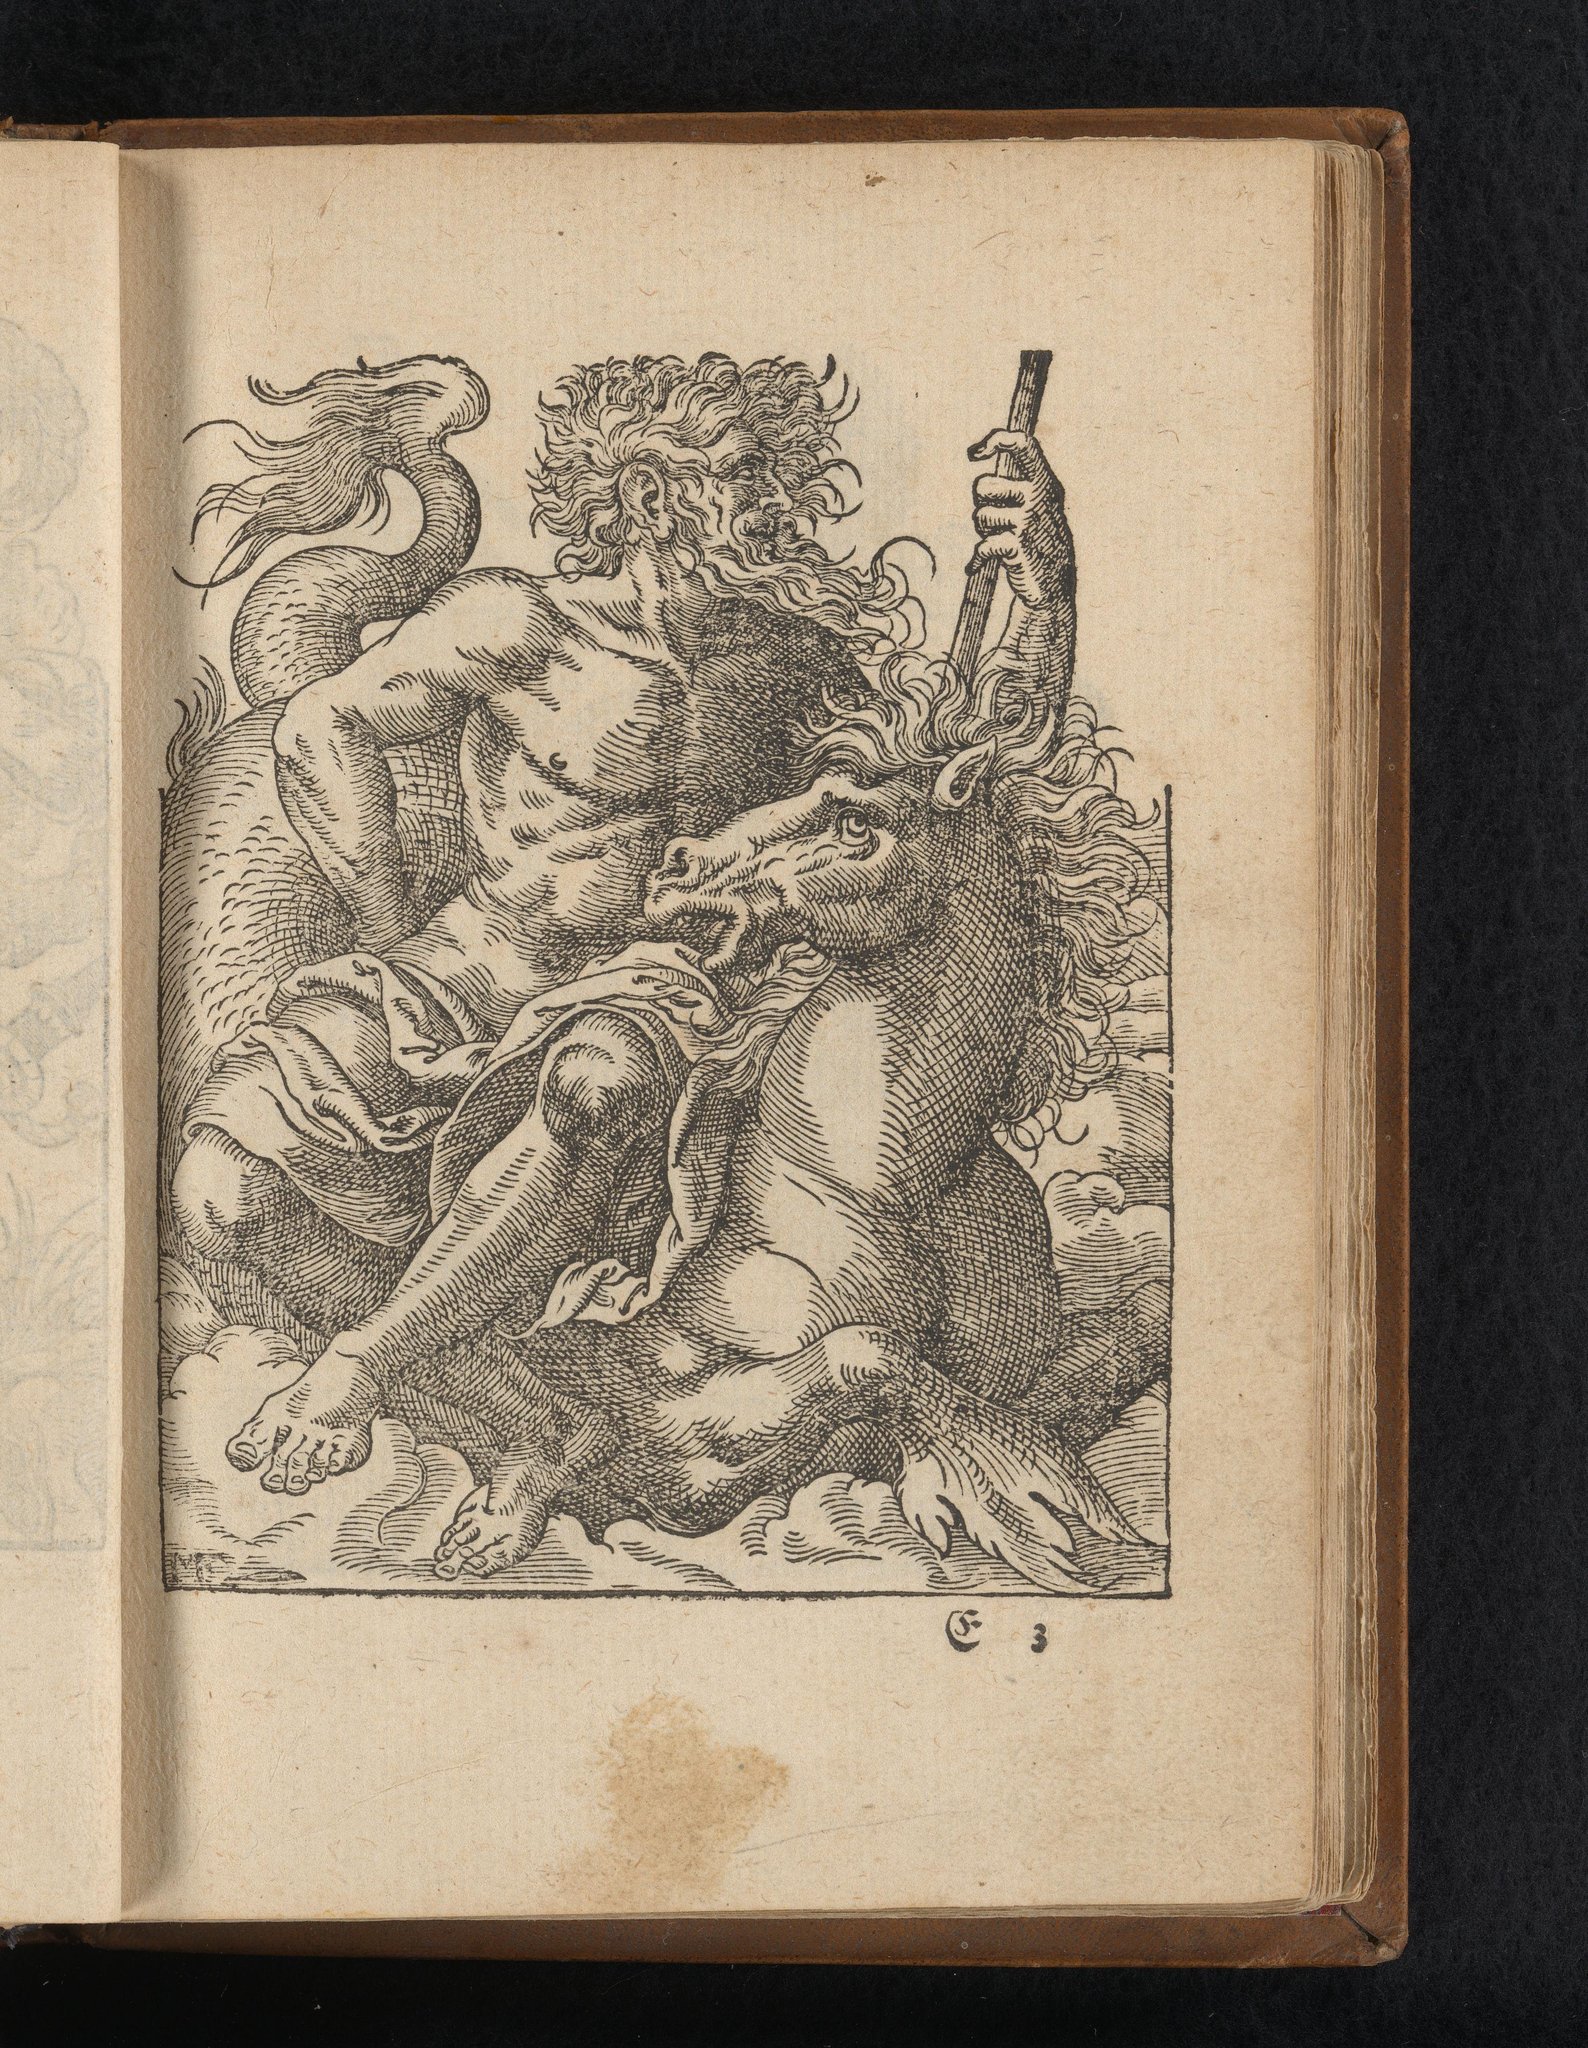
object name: print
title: Neptunus op een zeepaard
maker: monogrammist mf (duitsland)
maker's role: houtsnijder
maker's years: 1550-1599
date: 1578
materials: paper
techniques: woodcut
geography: nuremberg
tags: triumph of neptune, attributes of neptune (with name)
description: Triomf van Neptunus of een andere zeegod, op een zeepaard. Onderdeel van het modelboek Enchiridion artis pingendi, fingendi & sculpendi met 108 figuren bedoeld voor beginnende schilders, beeldhouwers en prentmakers.